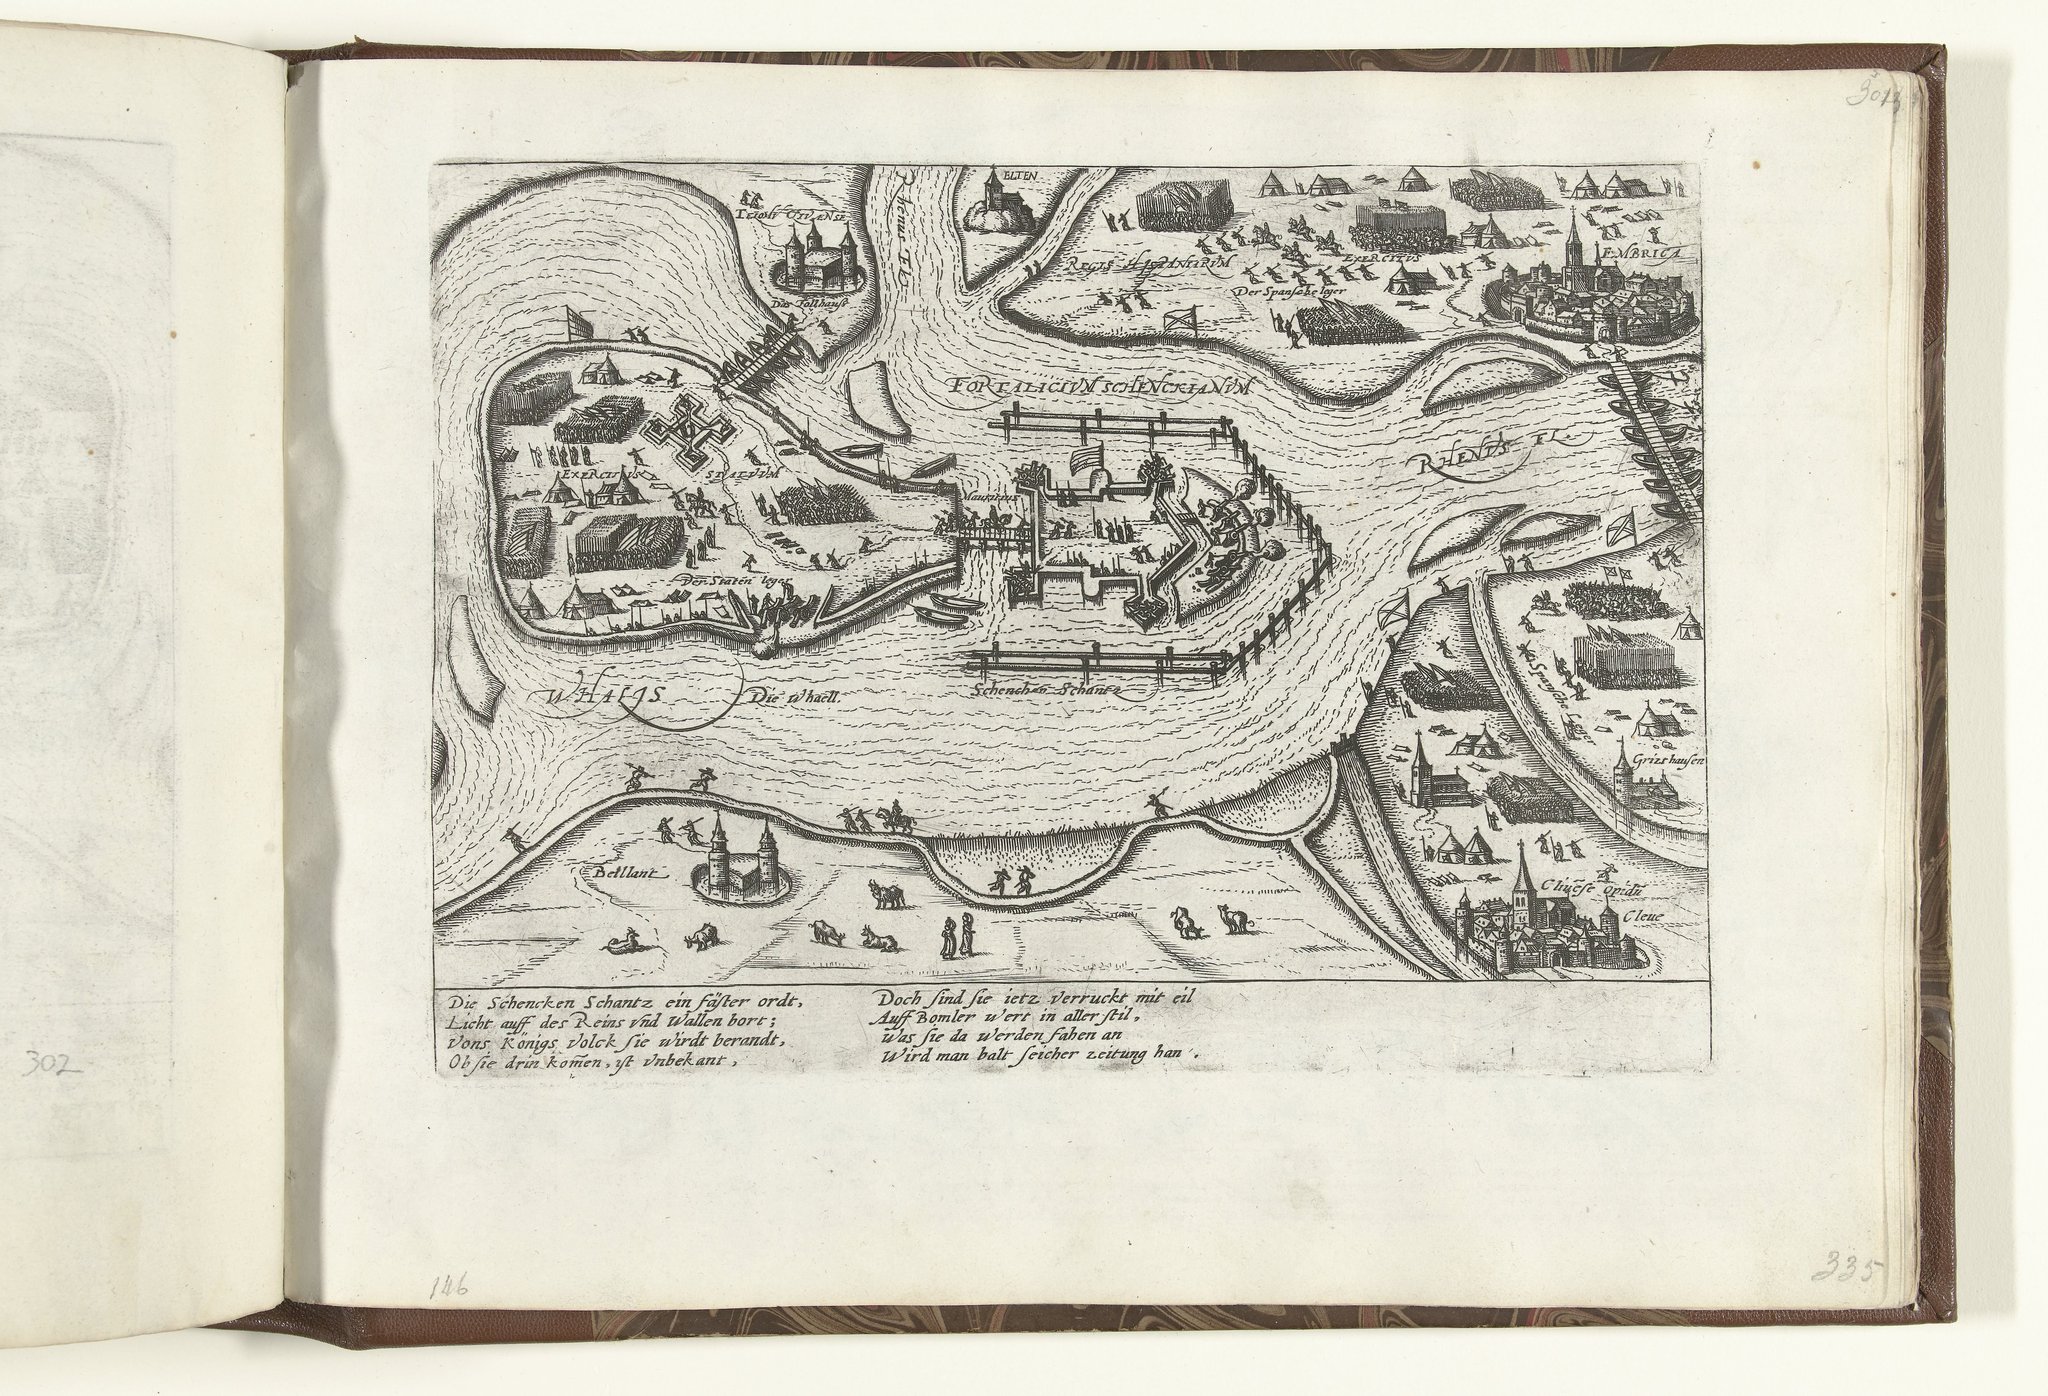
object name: print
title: Serie 10: Nederlandse en Buitenlandse Gebeurtenissen, 1587-1612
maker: frans hogenberg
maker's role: print maker, publisher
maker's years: 1538-1590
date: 1597-1599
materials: paper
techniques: etching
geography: cologne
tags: the hague, maurice (prince of orange), siege, position war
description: Beleg van Schenkenschans op de splitsing van de Rijn en de Waal door de Spanjaarden onder Mendoza, april 1599. Met onderschrift van 16 regels in het Duits. Ongenummerd.